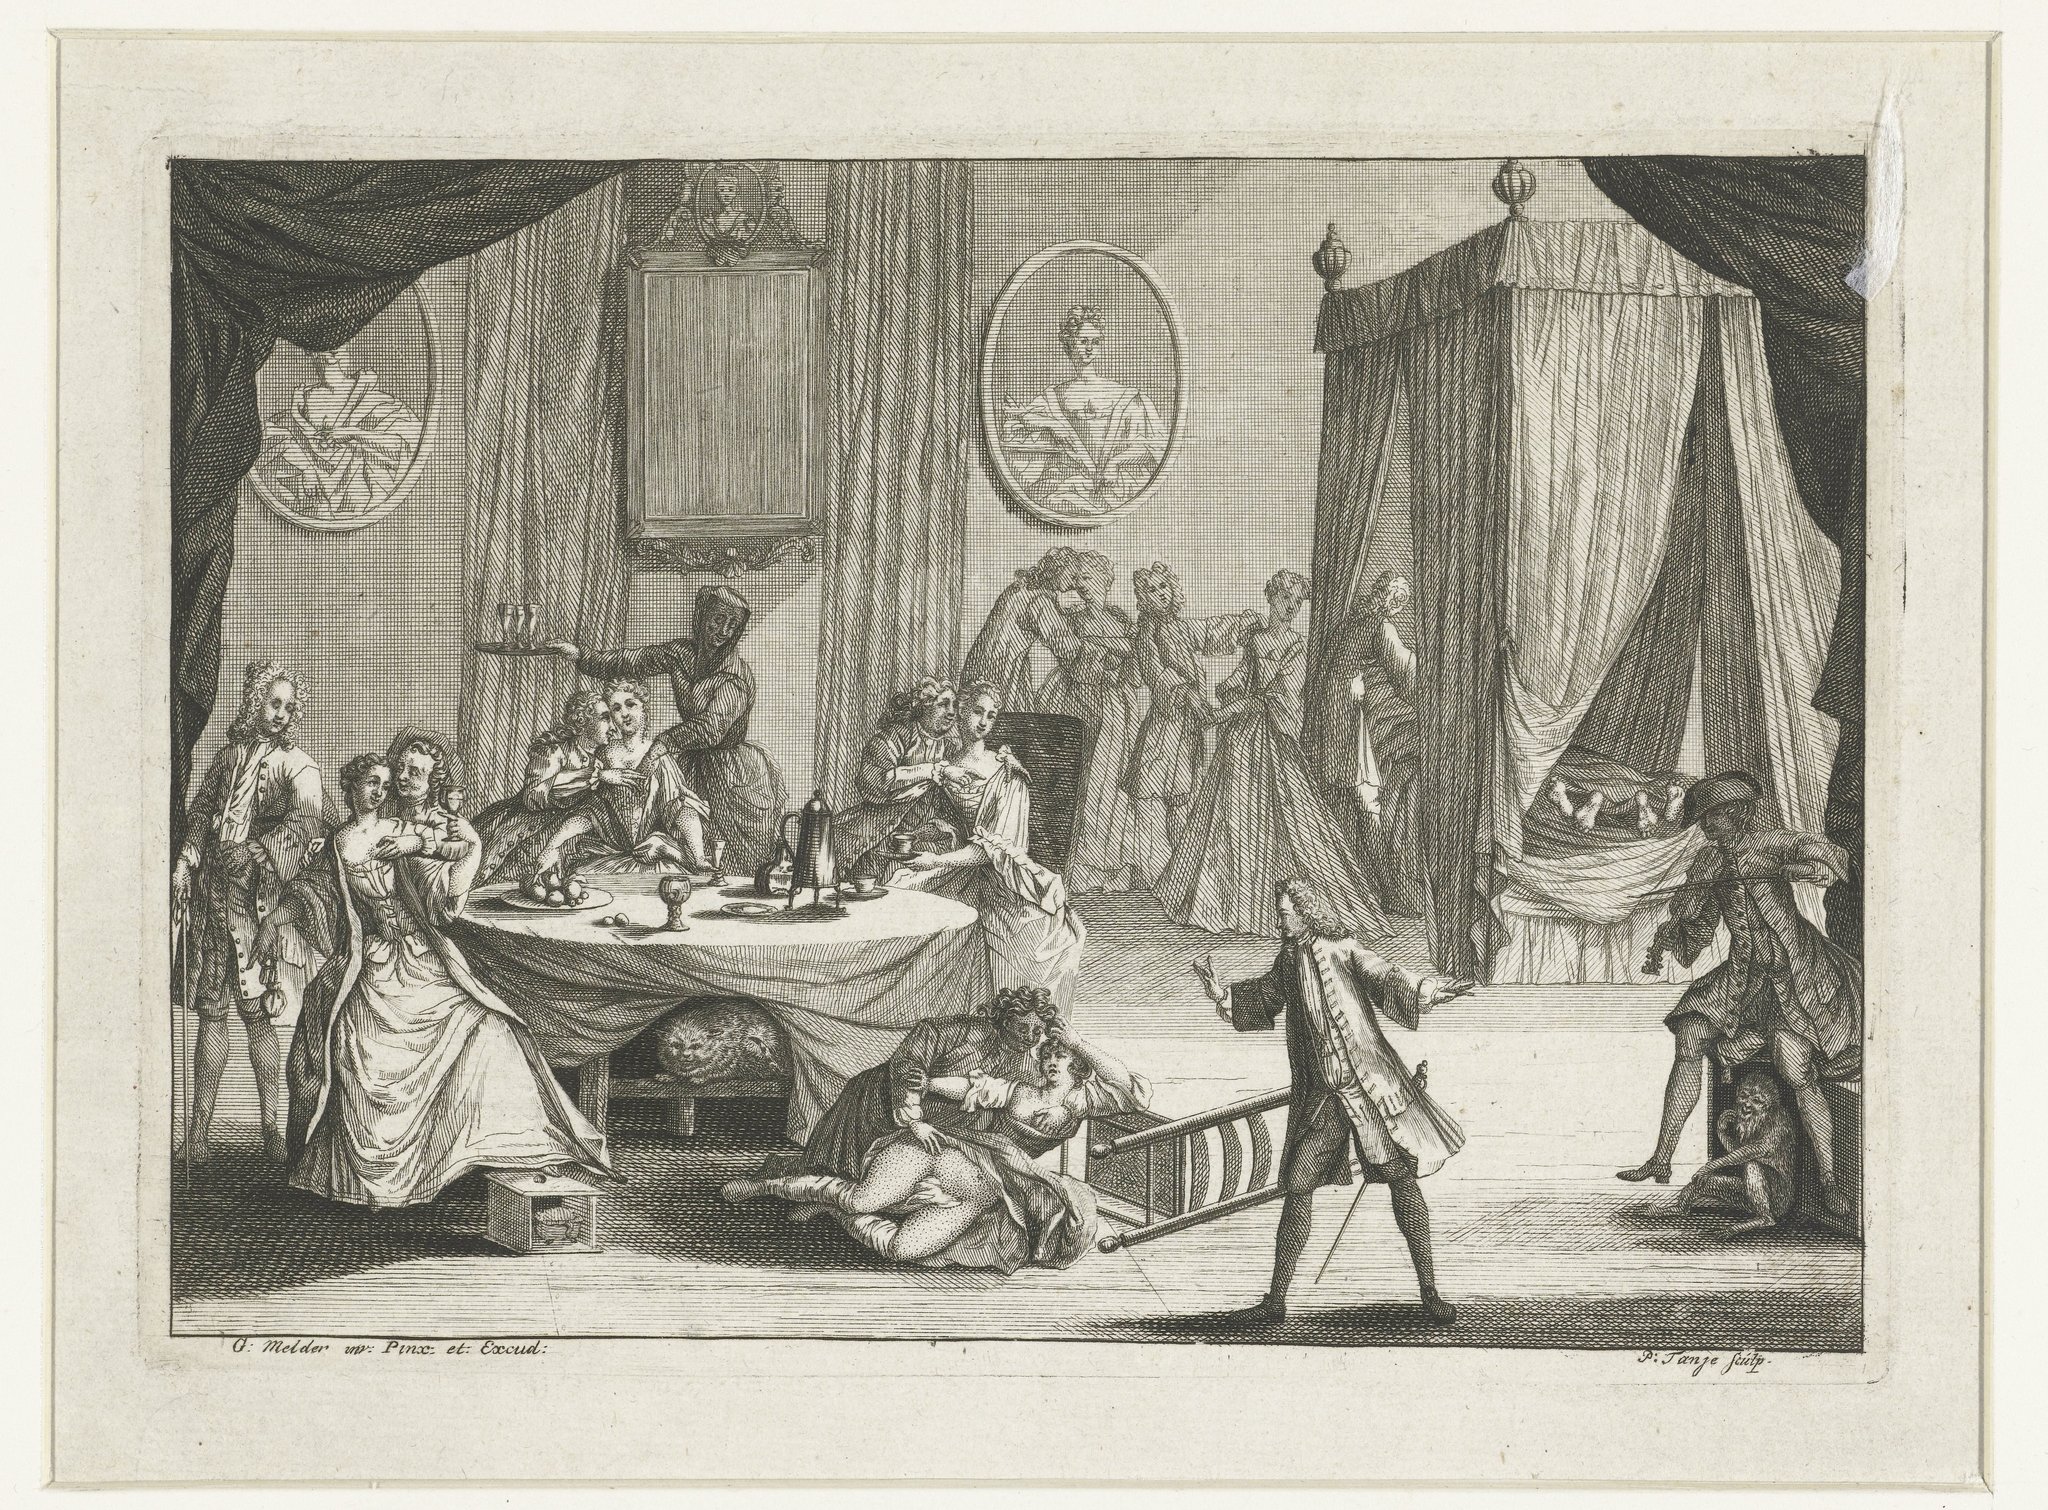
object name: print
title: The Farcical Discovery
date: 1750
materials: paper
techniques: engraving, etching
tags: (lovers) caressing each other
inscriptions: inscription: ‘Clement Marot op zijn praatstoel’, collector's mark: Lugt 240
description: The Naughty Tales Told by Clement Marot were assembled stories supposedly told by the 16th-century French poet. This print illustrates one such tale, in which the man surprises his wife involved in an orgy. She falls from her chair in shock because she thought he had gone hunting. The detail of the four feet peeping out from under the bed covers adds a burlesque twist.